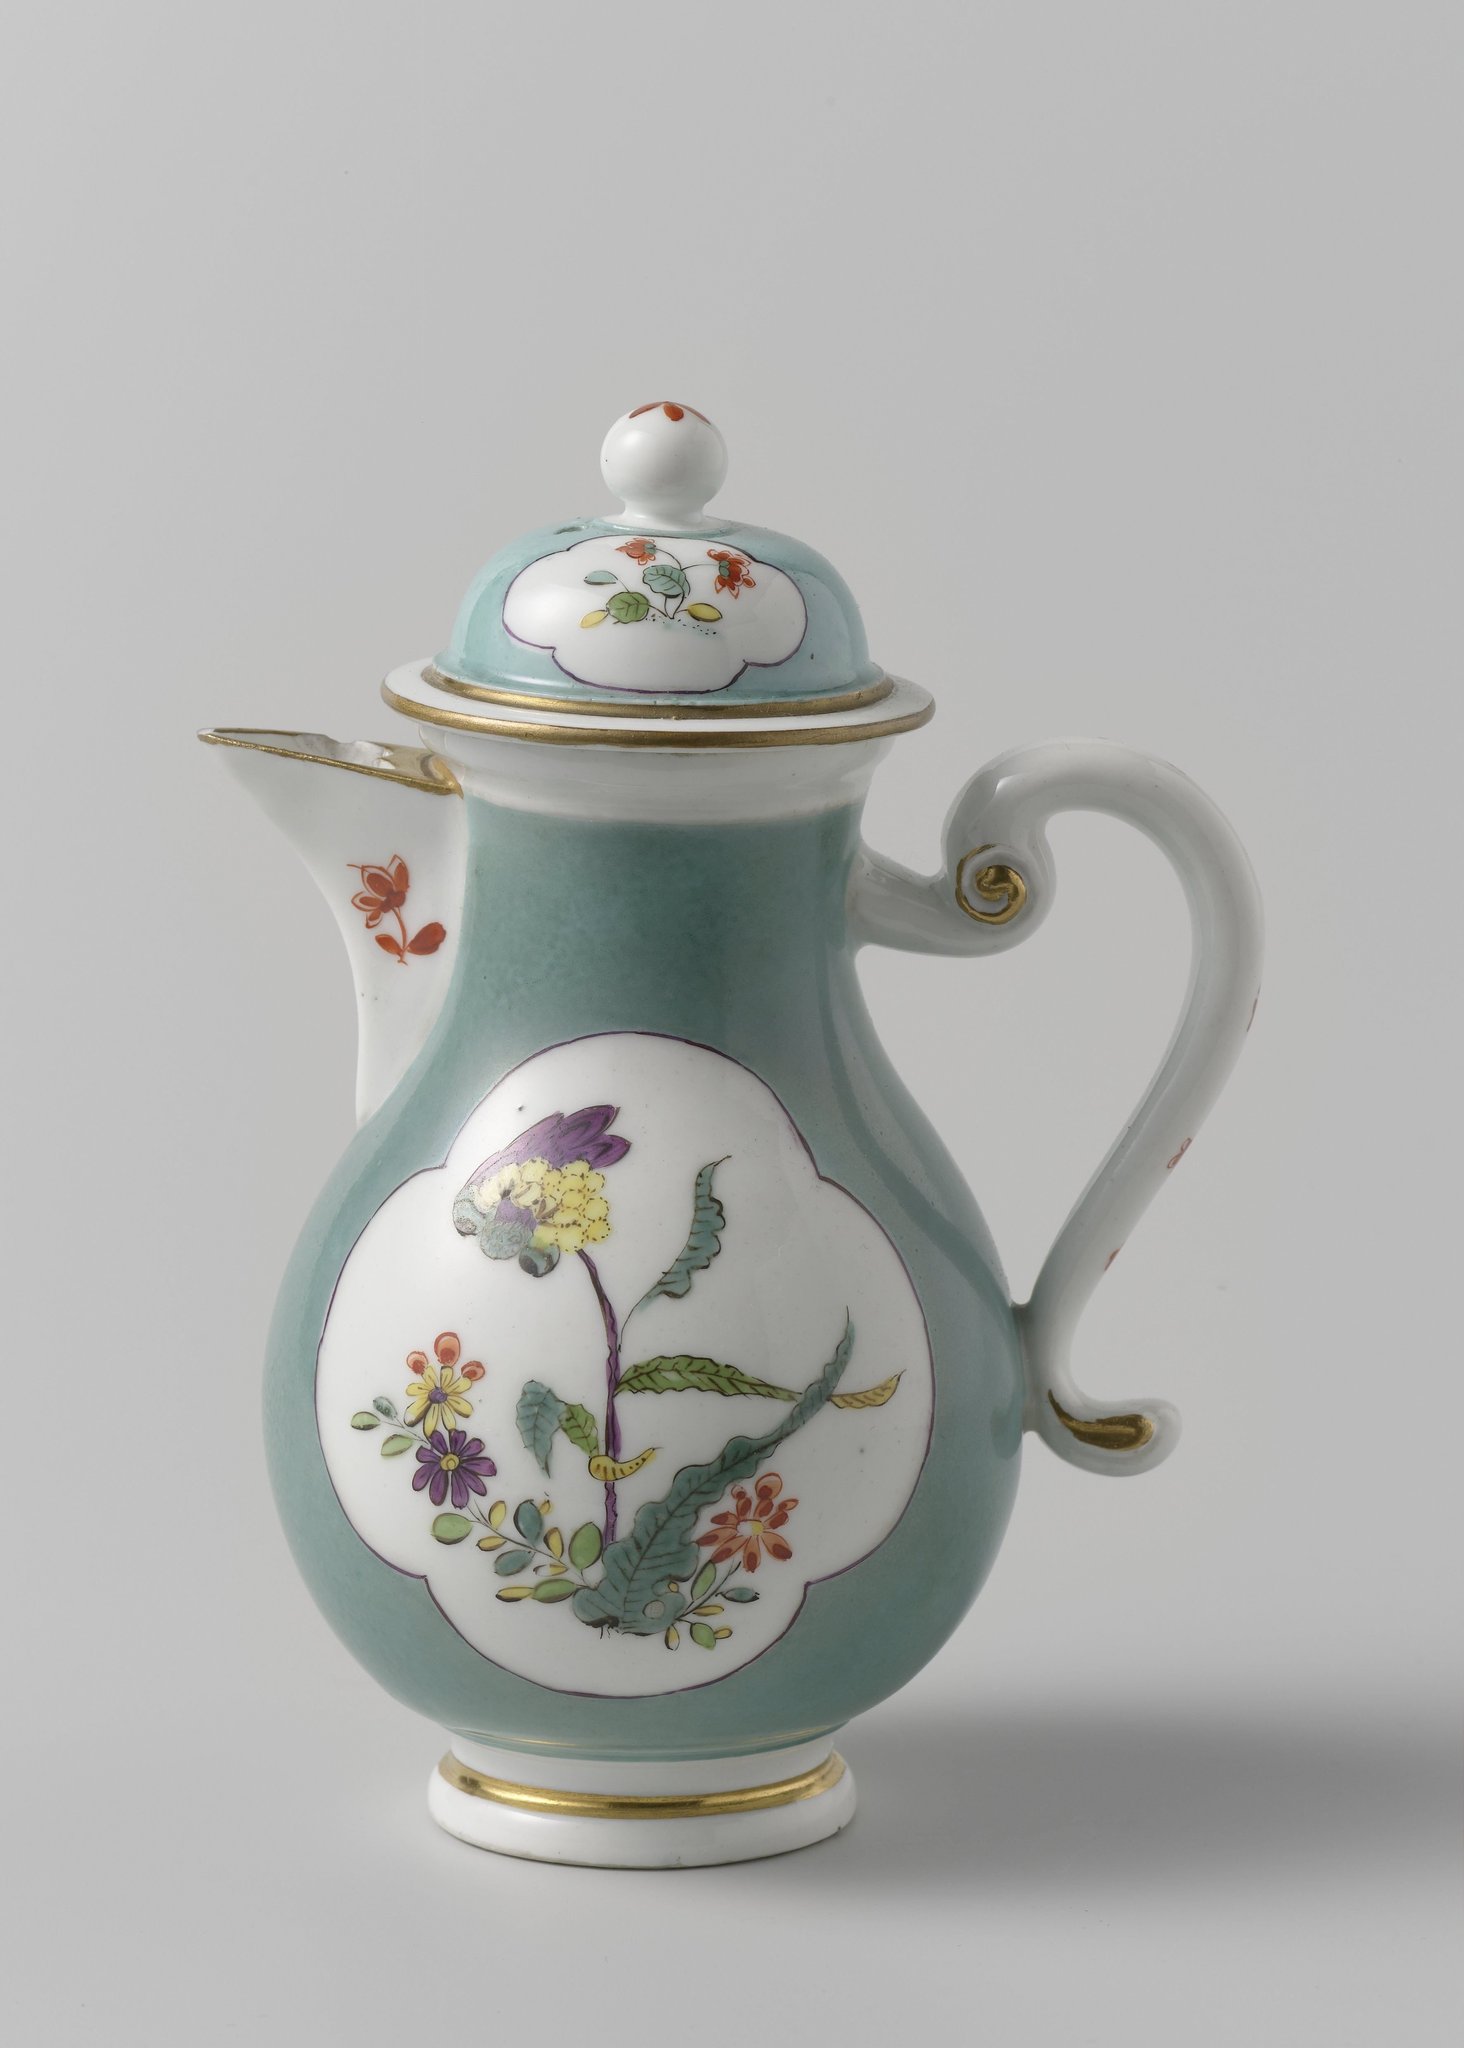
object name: lid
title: Deksel van melkkan, veelkleurig beschilderd met bloemtakken op een zeegroene fond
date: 1737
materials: porcelain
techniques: painted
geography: meissen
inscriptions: factory mark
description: Deksel van veelkleurig beschilderd porselein. Op de dekselknop een rozet.